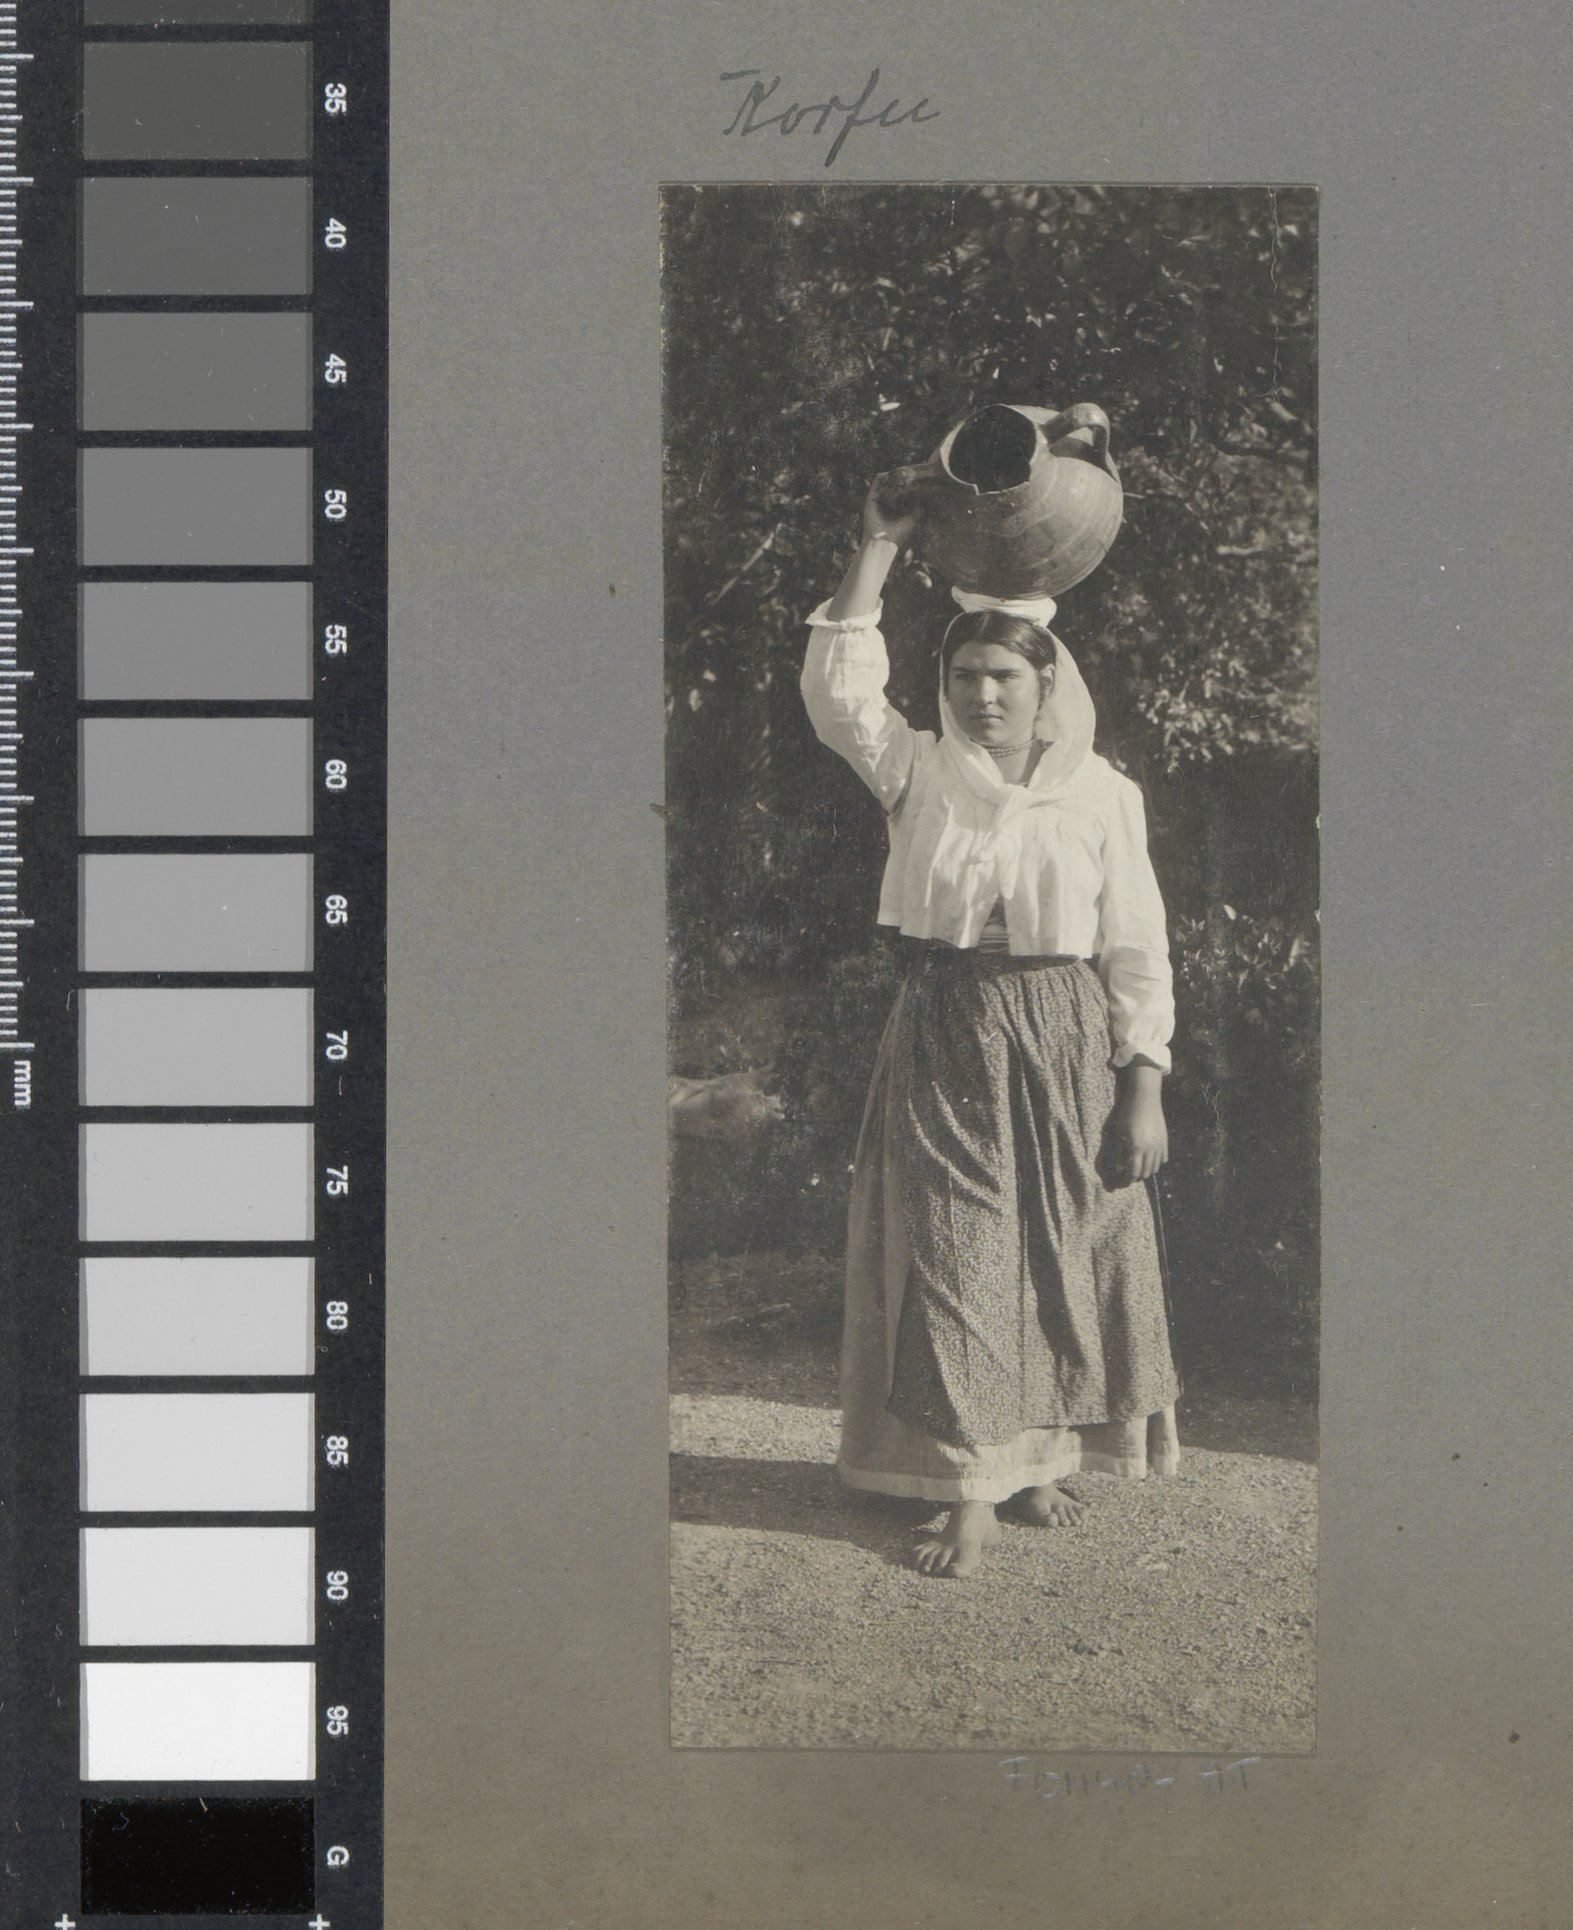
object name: photograph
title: Portret van een vrouw met een kruik op het hoofd op Corfu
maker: Anonymous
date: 1895-1905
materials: paper, photographic support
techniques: gelatin silver print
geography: corfu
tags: folk costume, regional costume (+ women's clothes), container of ceramics: jar, jug, pot, vase, carrying something on the head or on the shoulders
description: Onderdeel van Reisalbum met foto's van bezienswaardigheden in Griekenland en Egypte.